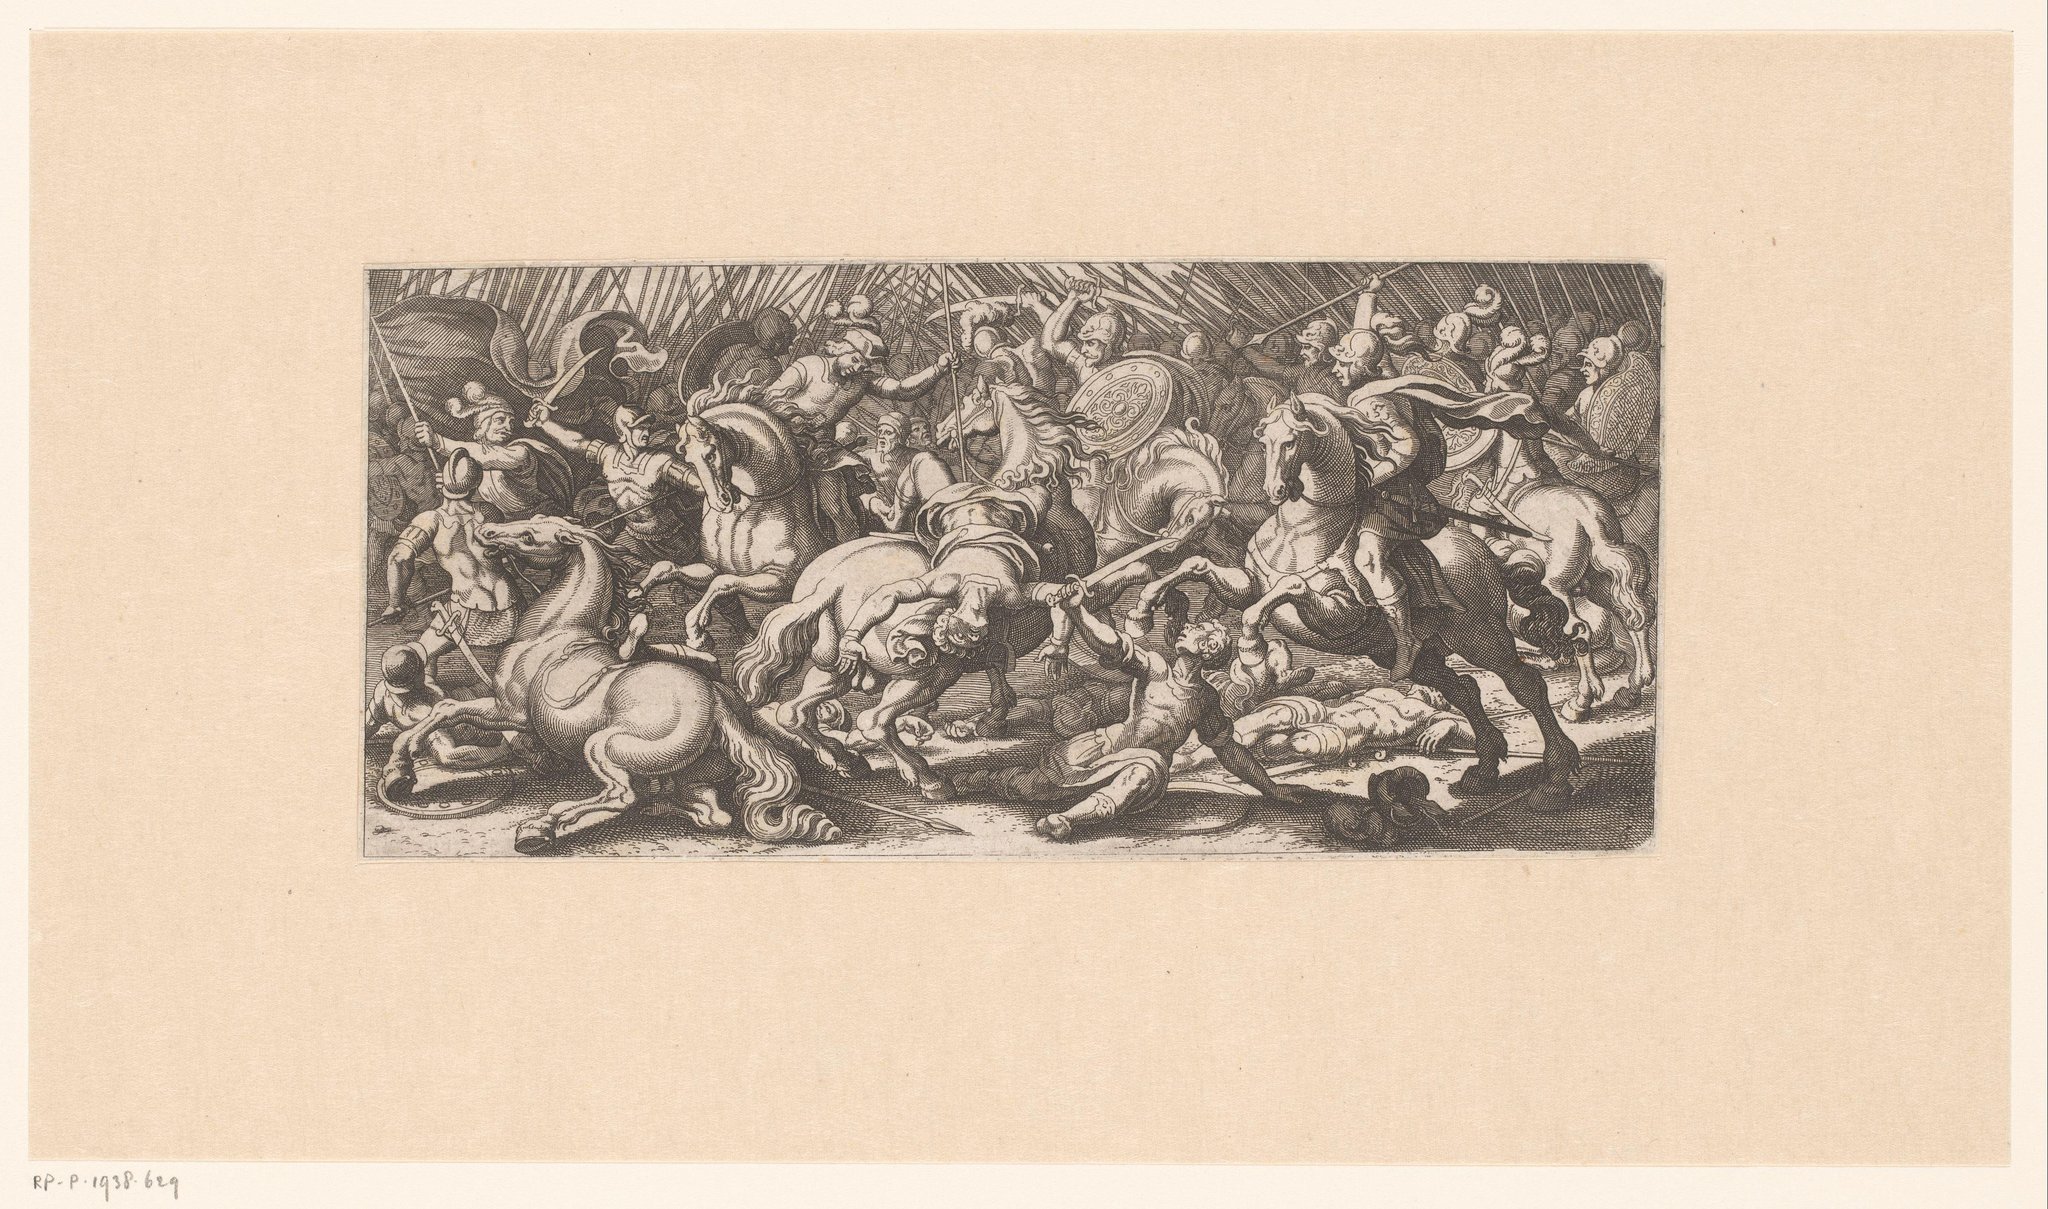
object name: print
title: Gevecht tussen cavaleristen en infanteristen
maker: etienne delaune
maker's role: draughtsman, goldsmith, print maker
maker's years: 1519-1583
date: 1528-1583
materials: paper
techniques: engraving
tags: battle, military discipline (+ cavalry, horsemen), military discipline (+ infantry)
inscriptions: collector's mark: Lugt 2228, collector's mark: Lugt 2760